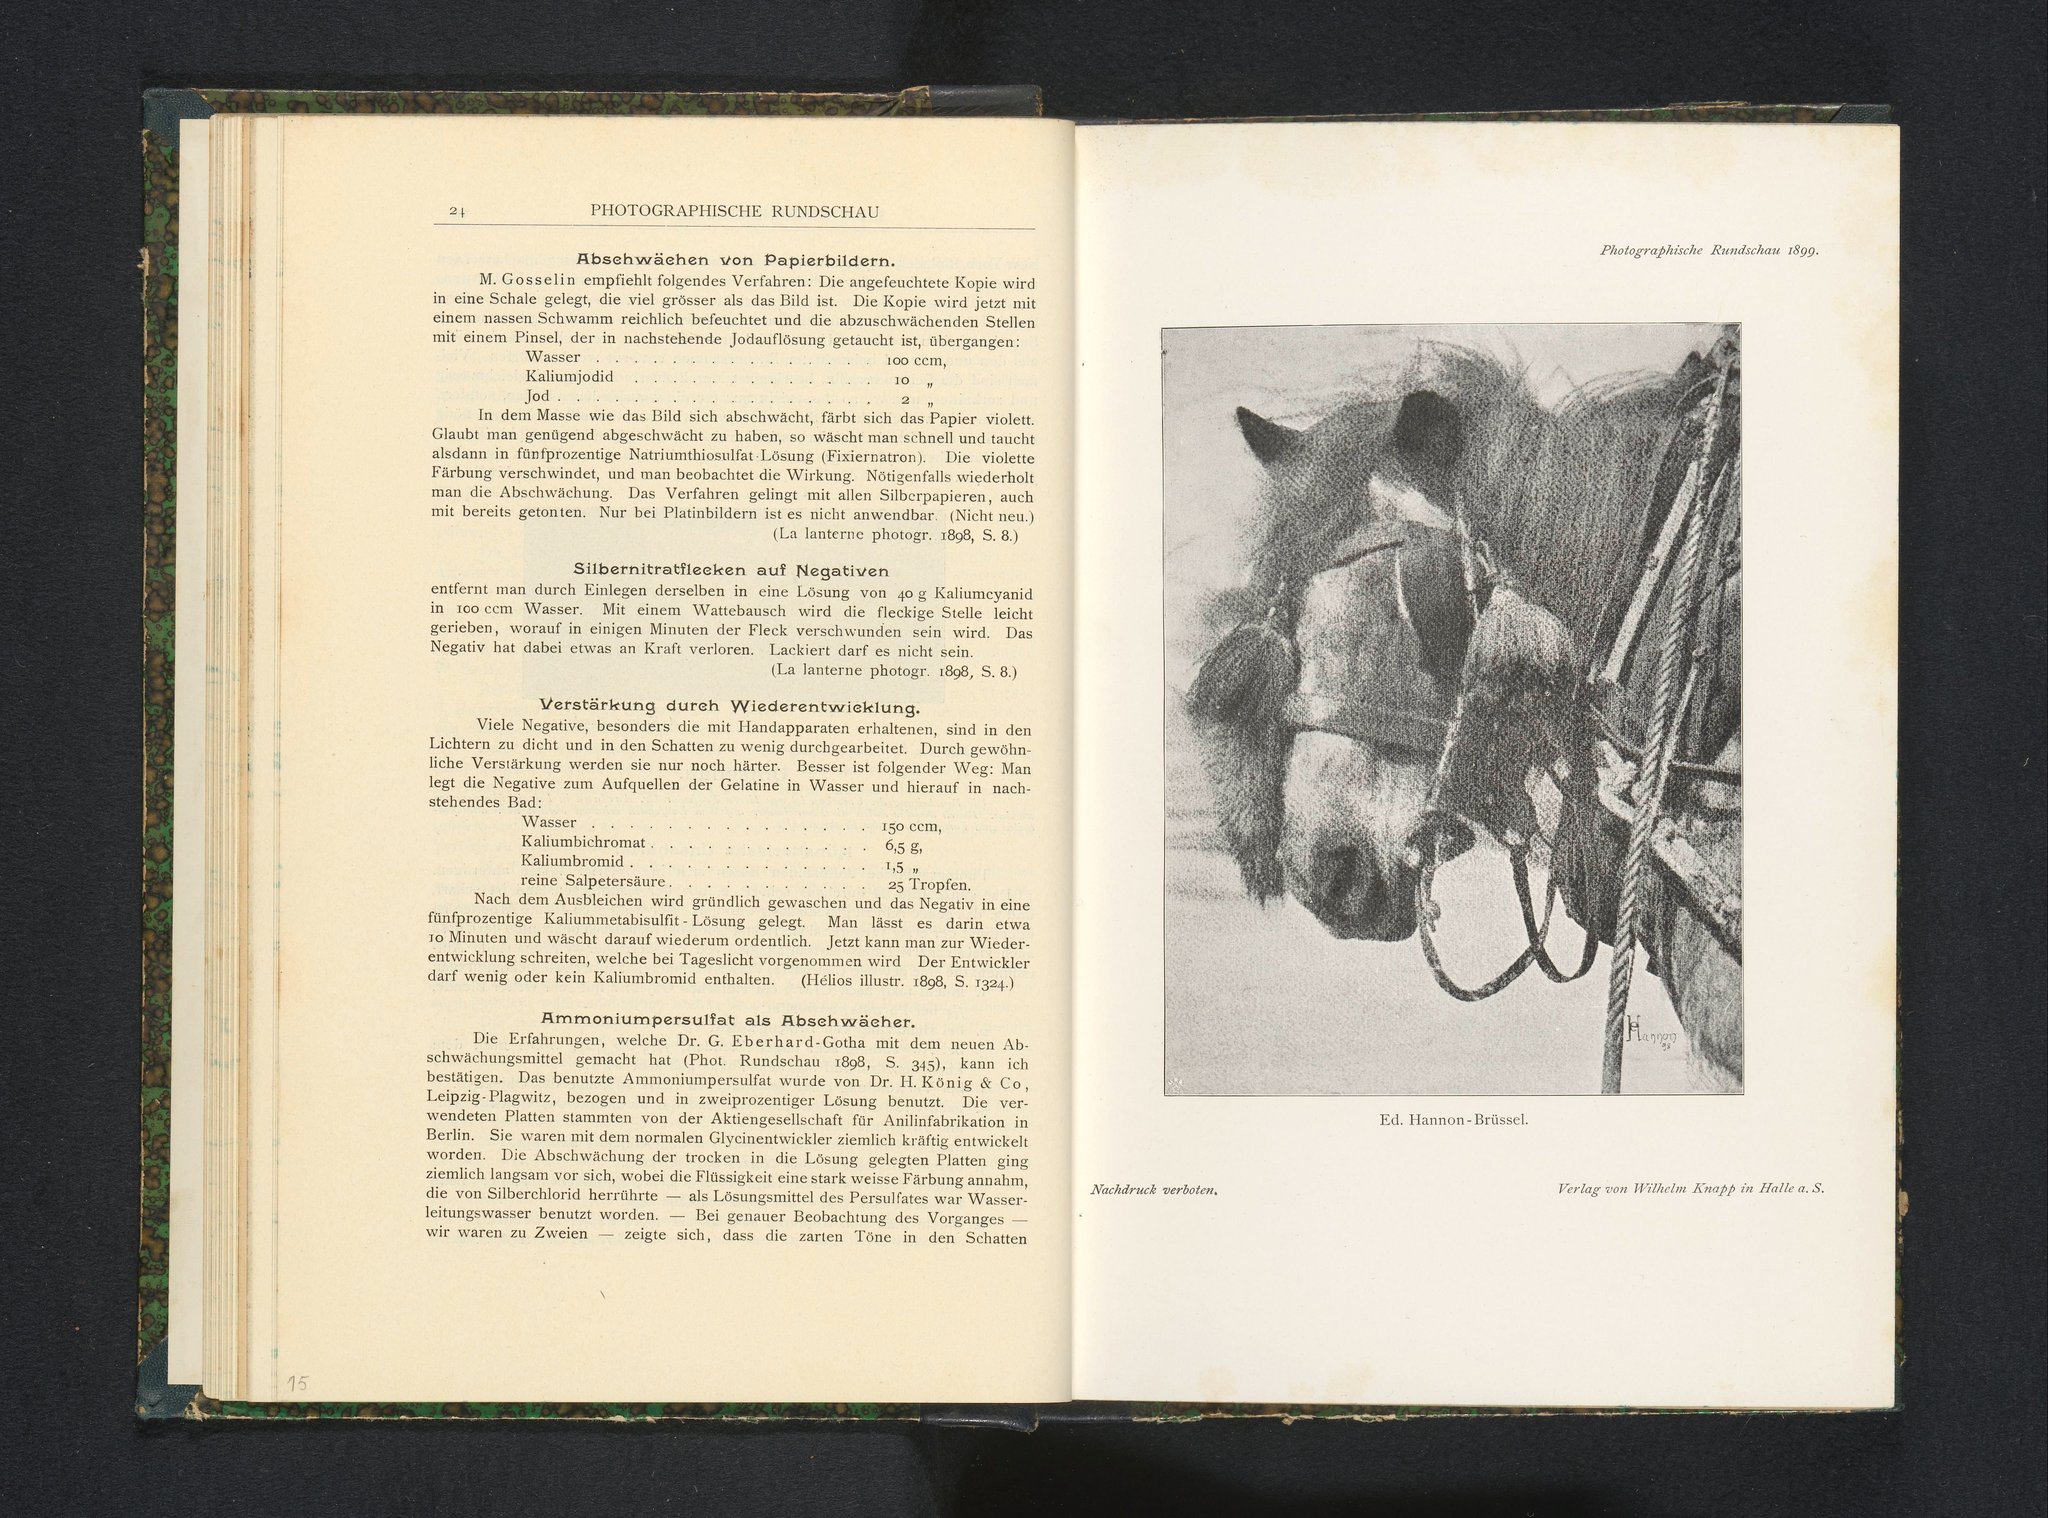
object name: photomechanical print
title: Ed. Hannon - Brüssel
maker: ed. hannon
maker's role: fotograaf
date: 1898-1899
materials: paper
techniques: autotype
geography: halle an der saale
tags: blinkers, head-stall, horse